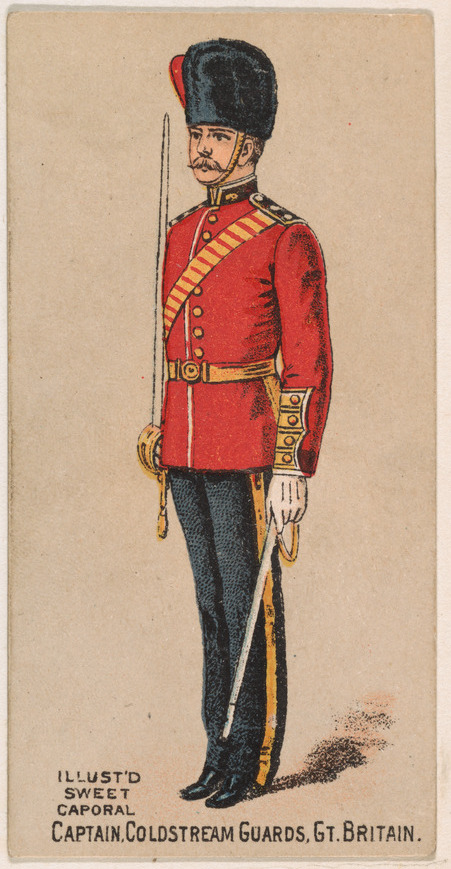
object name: print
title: Captain, Coldstream Guards, Great Britain, from the Military Series (N224) issued by Kinney Tobacco Company to promote Sweet Caporal Cigarettes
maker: kinney brothers tobacco company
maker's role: publisher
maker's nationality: american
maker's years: 1869-2011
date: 1888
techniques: color lithograph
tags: soldiers,swords,men